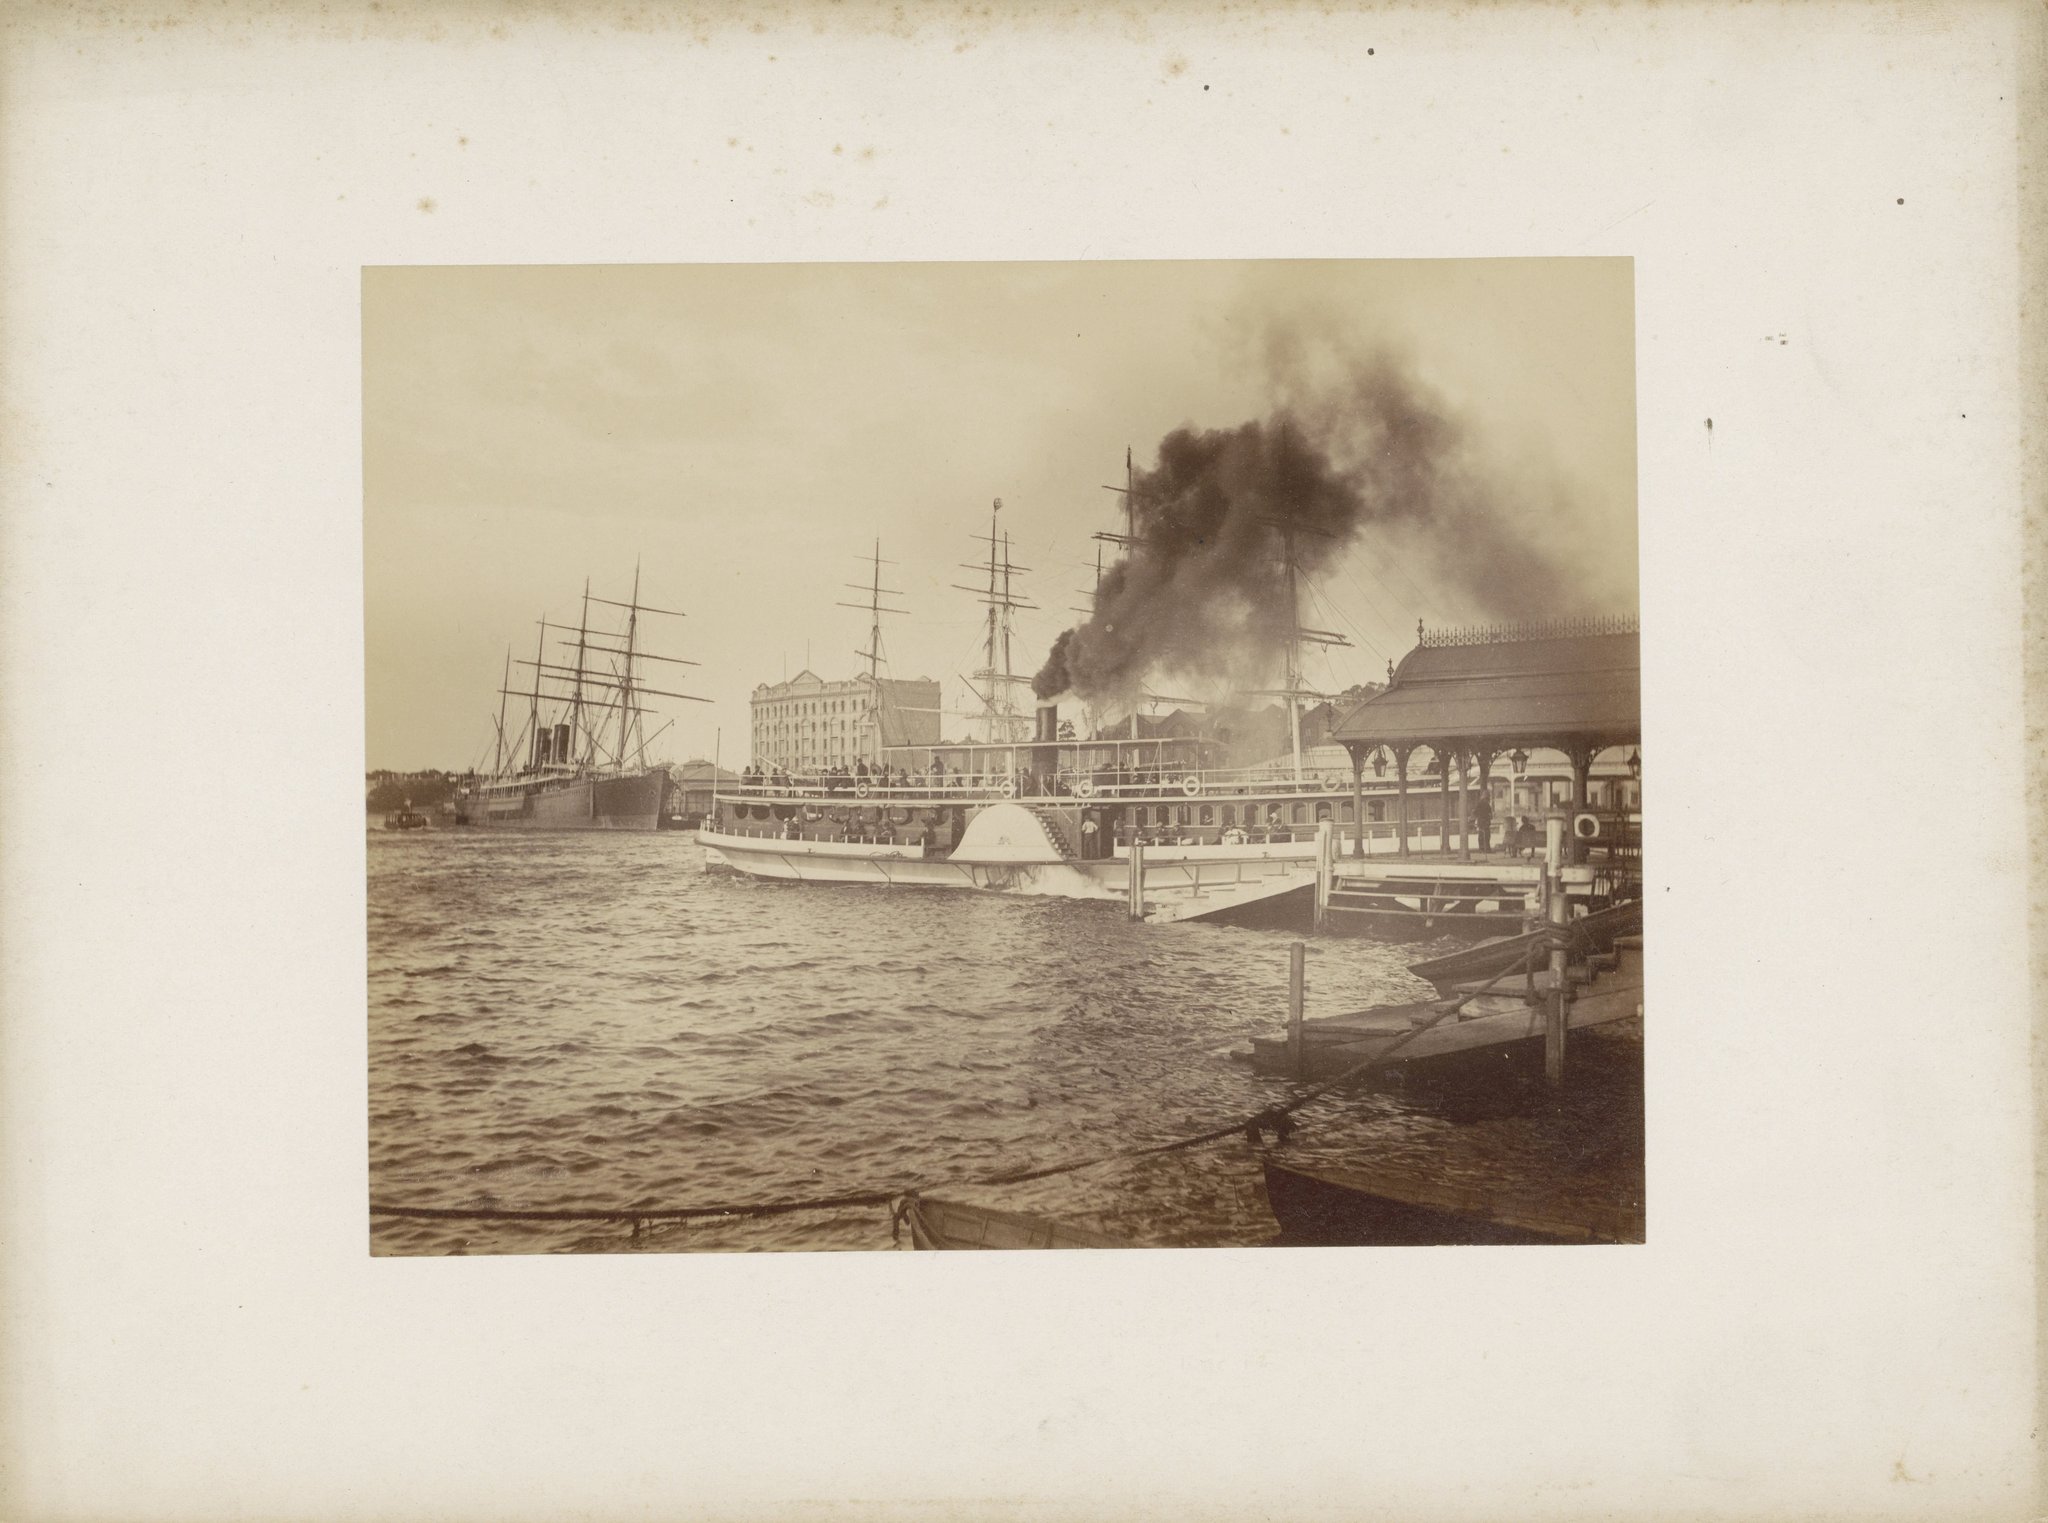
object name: album leaf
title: Raderboor met dampende schoorsteen, vermoedelijk in de haven van Sydney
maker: charles bayliss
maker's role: fotograaf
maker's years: 1850-1897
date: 1890-1910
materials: cardboard, paper, photographic support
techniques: albumen print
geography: sydney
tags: harbour (+ view ~ vehicle, ship, etc.), paddle-wheel boat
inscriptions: check stamp: ‘C. Bayliss Photo Sydney’, inscription: ‘uit map met foto's van Sydney gekocht Waterlooplein Amsterdam 1963 à f 0,10’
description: Onderdeel van Reisalbum met foto's van bezienswaardigheden in Sydney.